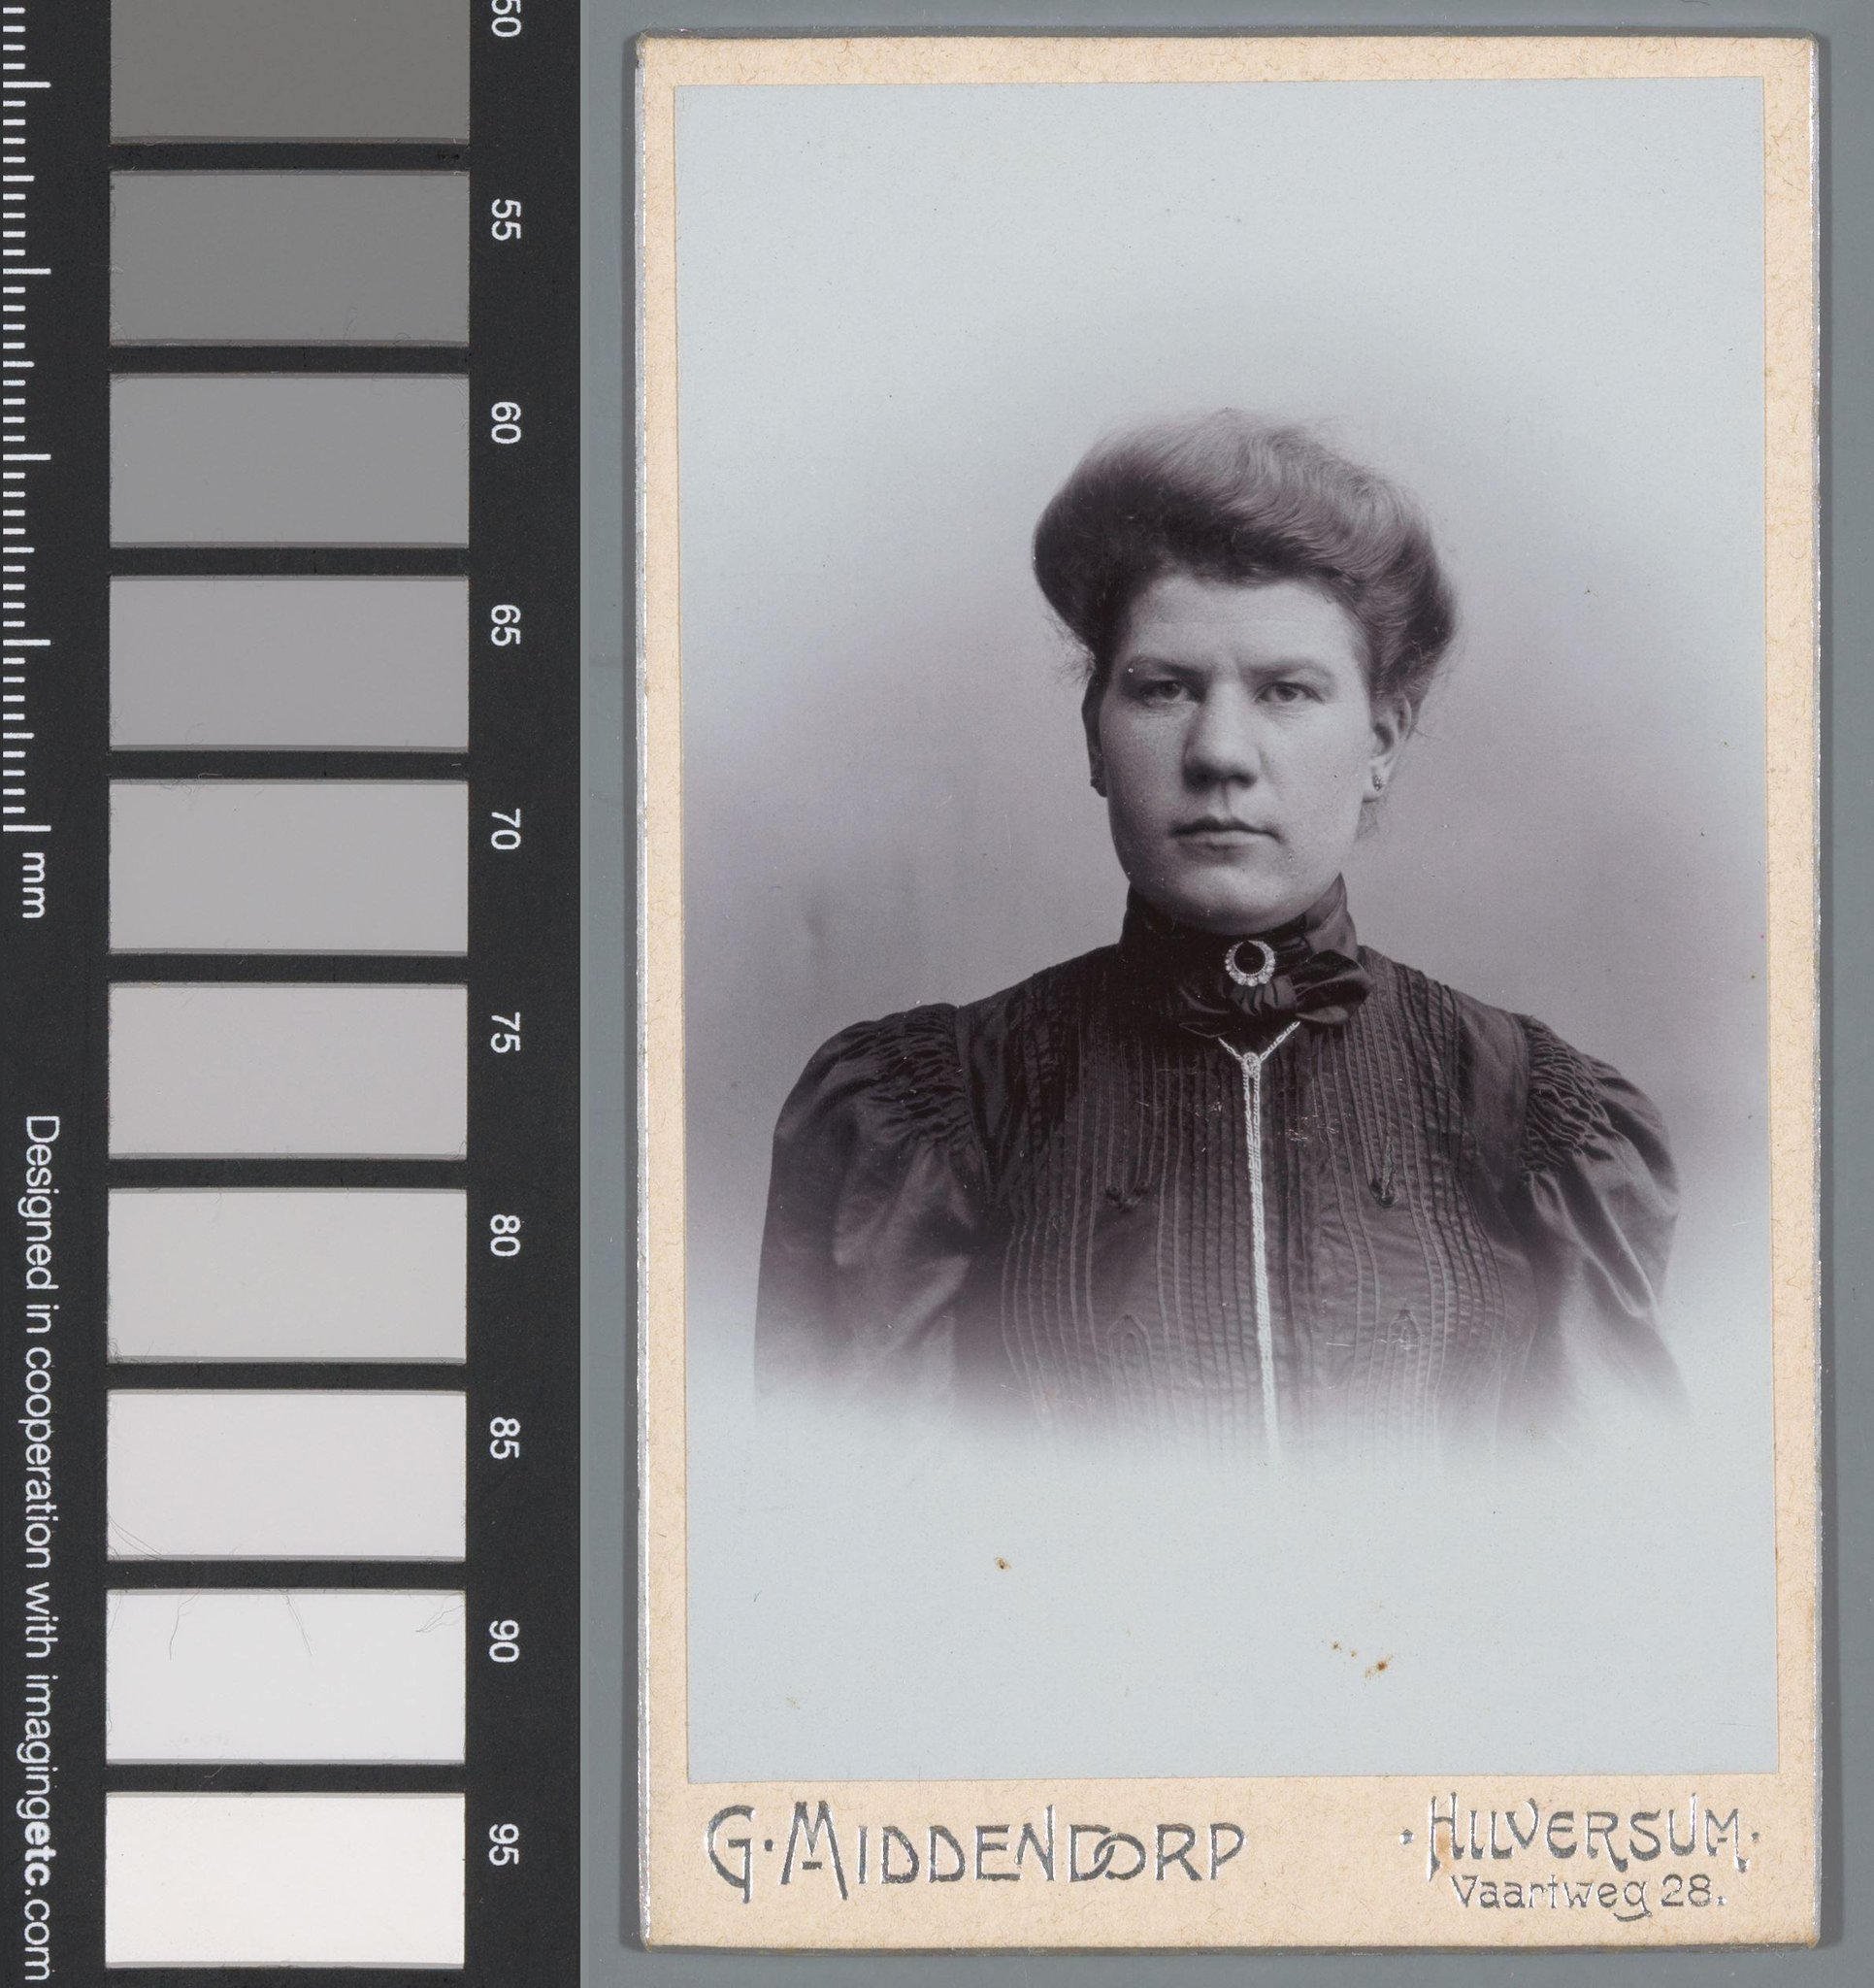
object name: carte de visite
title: Portret van een onbekende vrouw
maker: johannes gerard middendorp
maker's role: fotograaf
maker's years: 1870-1949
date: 1900-1920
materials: cardboard, photographic support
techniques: collodion silver print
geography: hilversum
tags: historical persons - bb - woman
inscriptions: inscription: ‘G. MIDDENDORP/ FOTOGRAAF/ HILVERSUM/ Vaartweg 28/ De Plaat blijft voor nabestelling bewaard.’